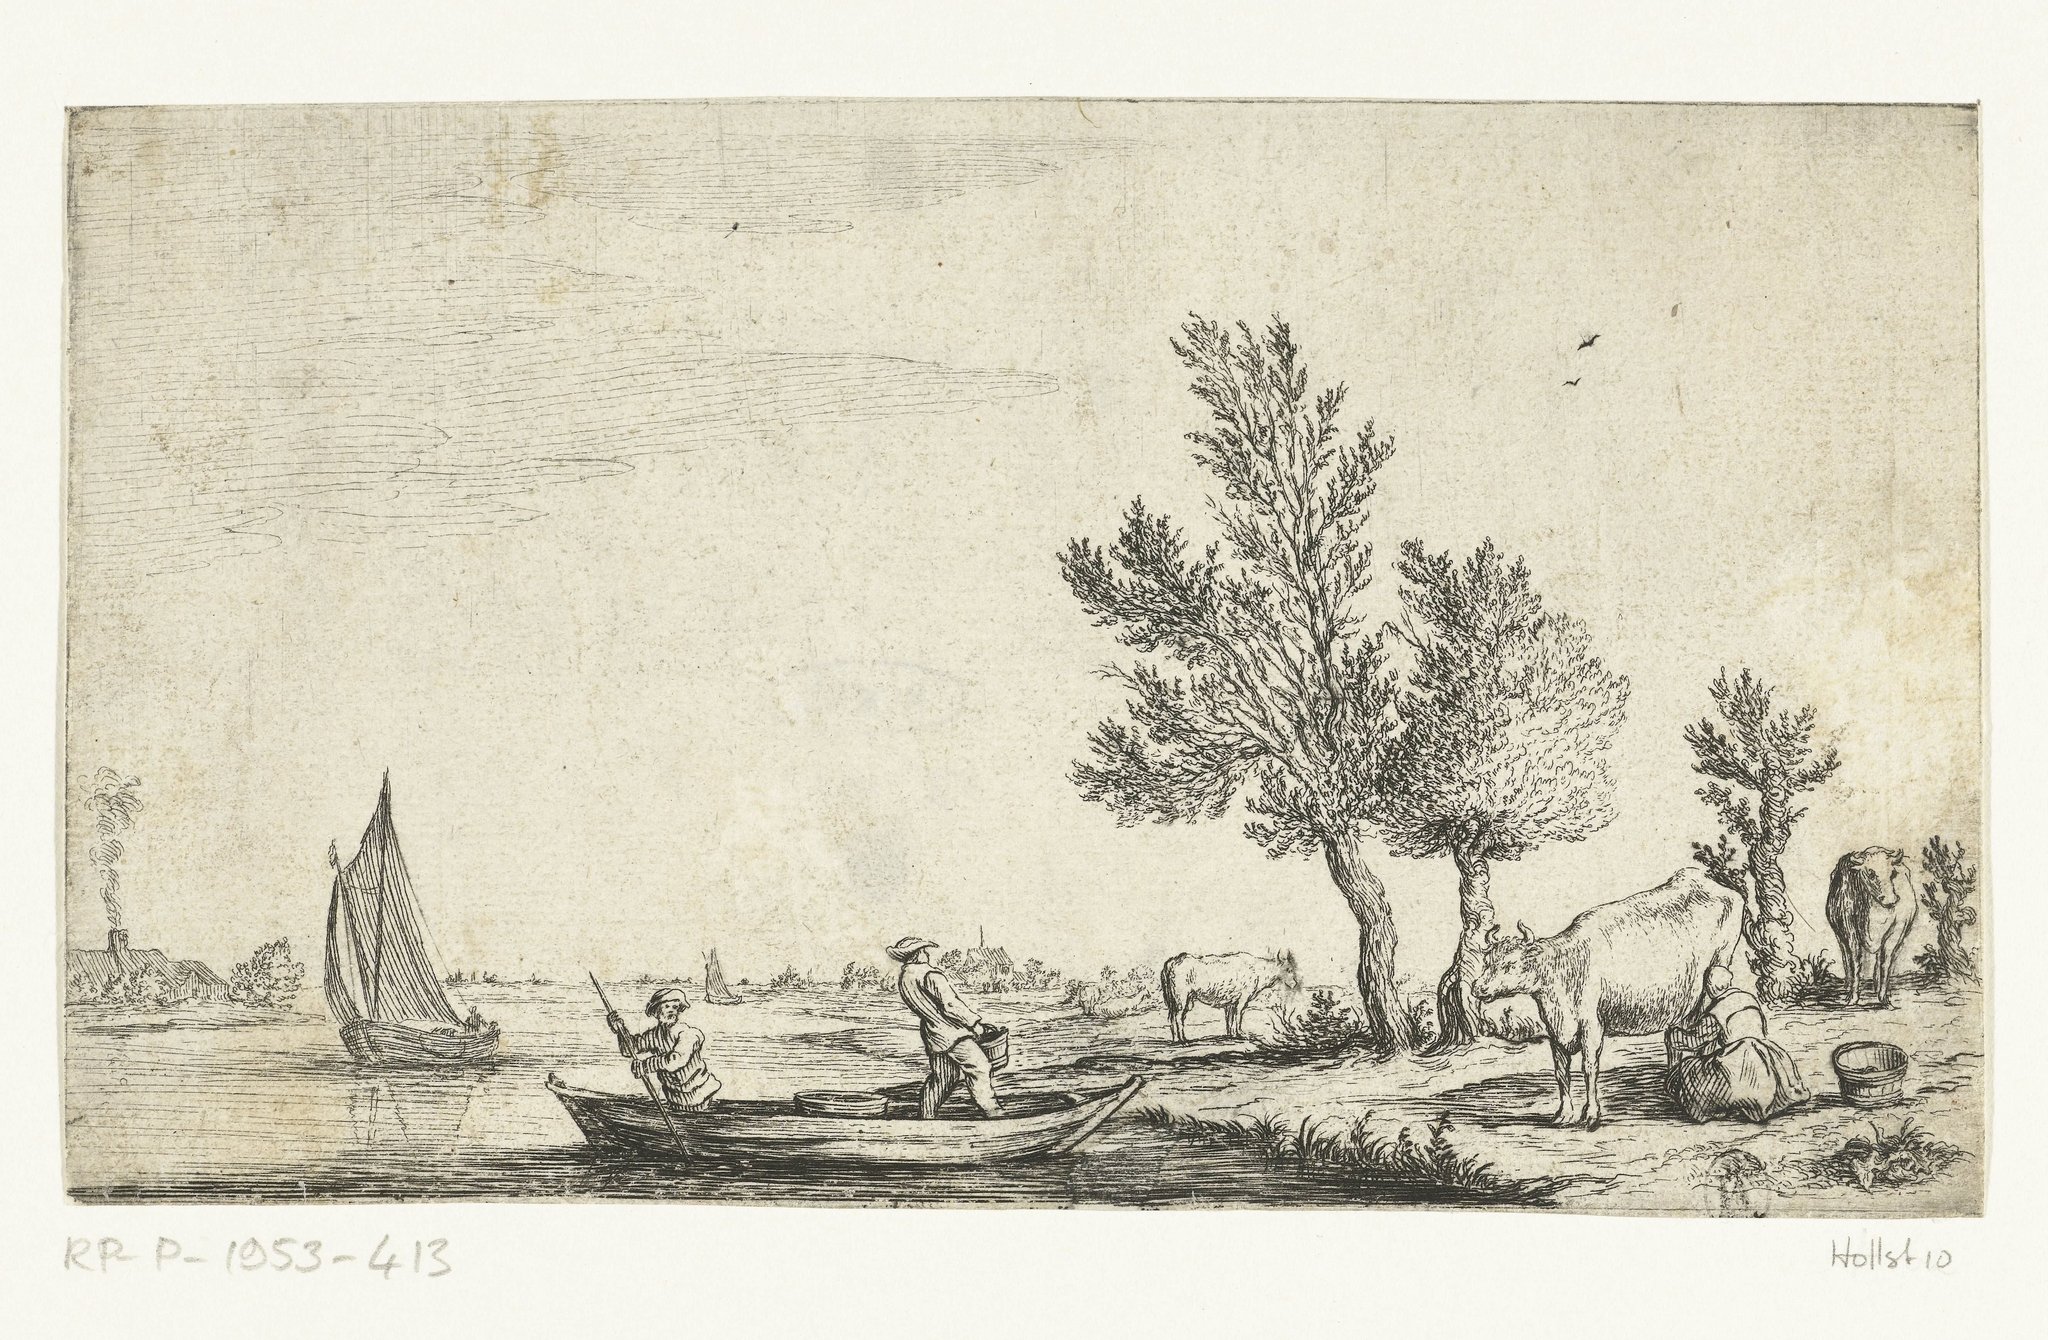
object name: print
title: Rivierlandschap met twee mannen in een roeiboot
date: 1640-1679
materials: paper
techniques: etching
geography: netherlands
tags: rowing-boat, canoe, etc.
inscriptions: collector's mark: Lugt 2228, collector's mark: Lugt 2760, collector's mark: Lugt 971